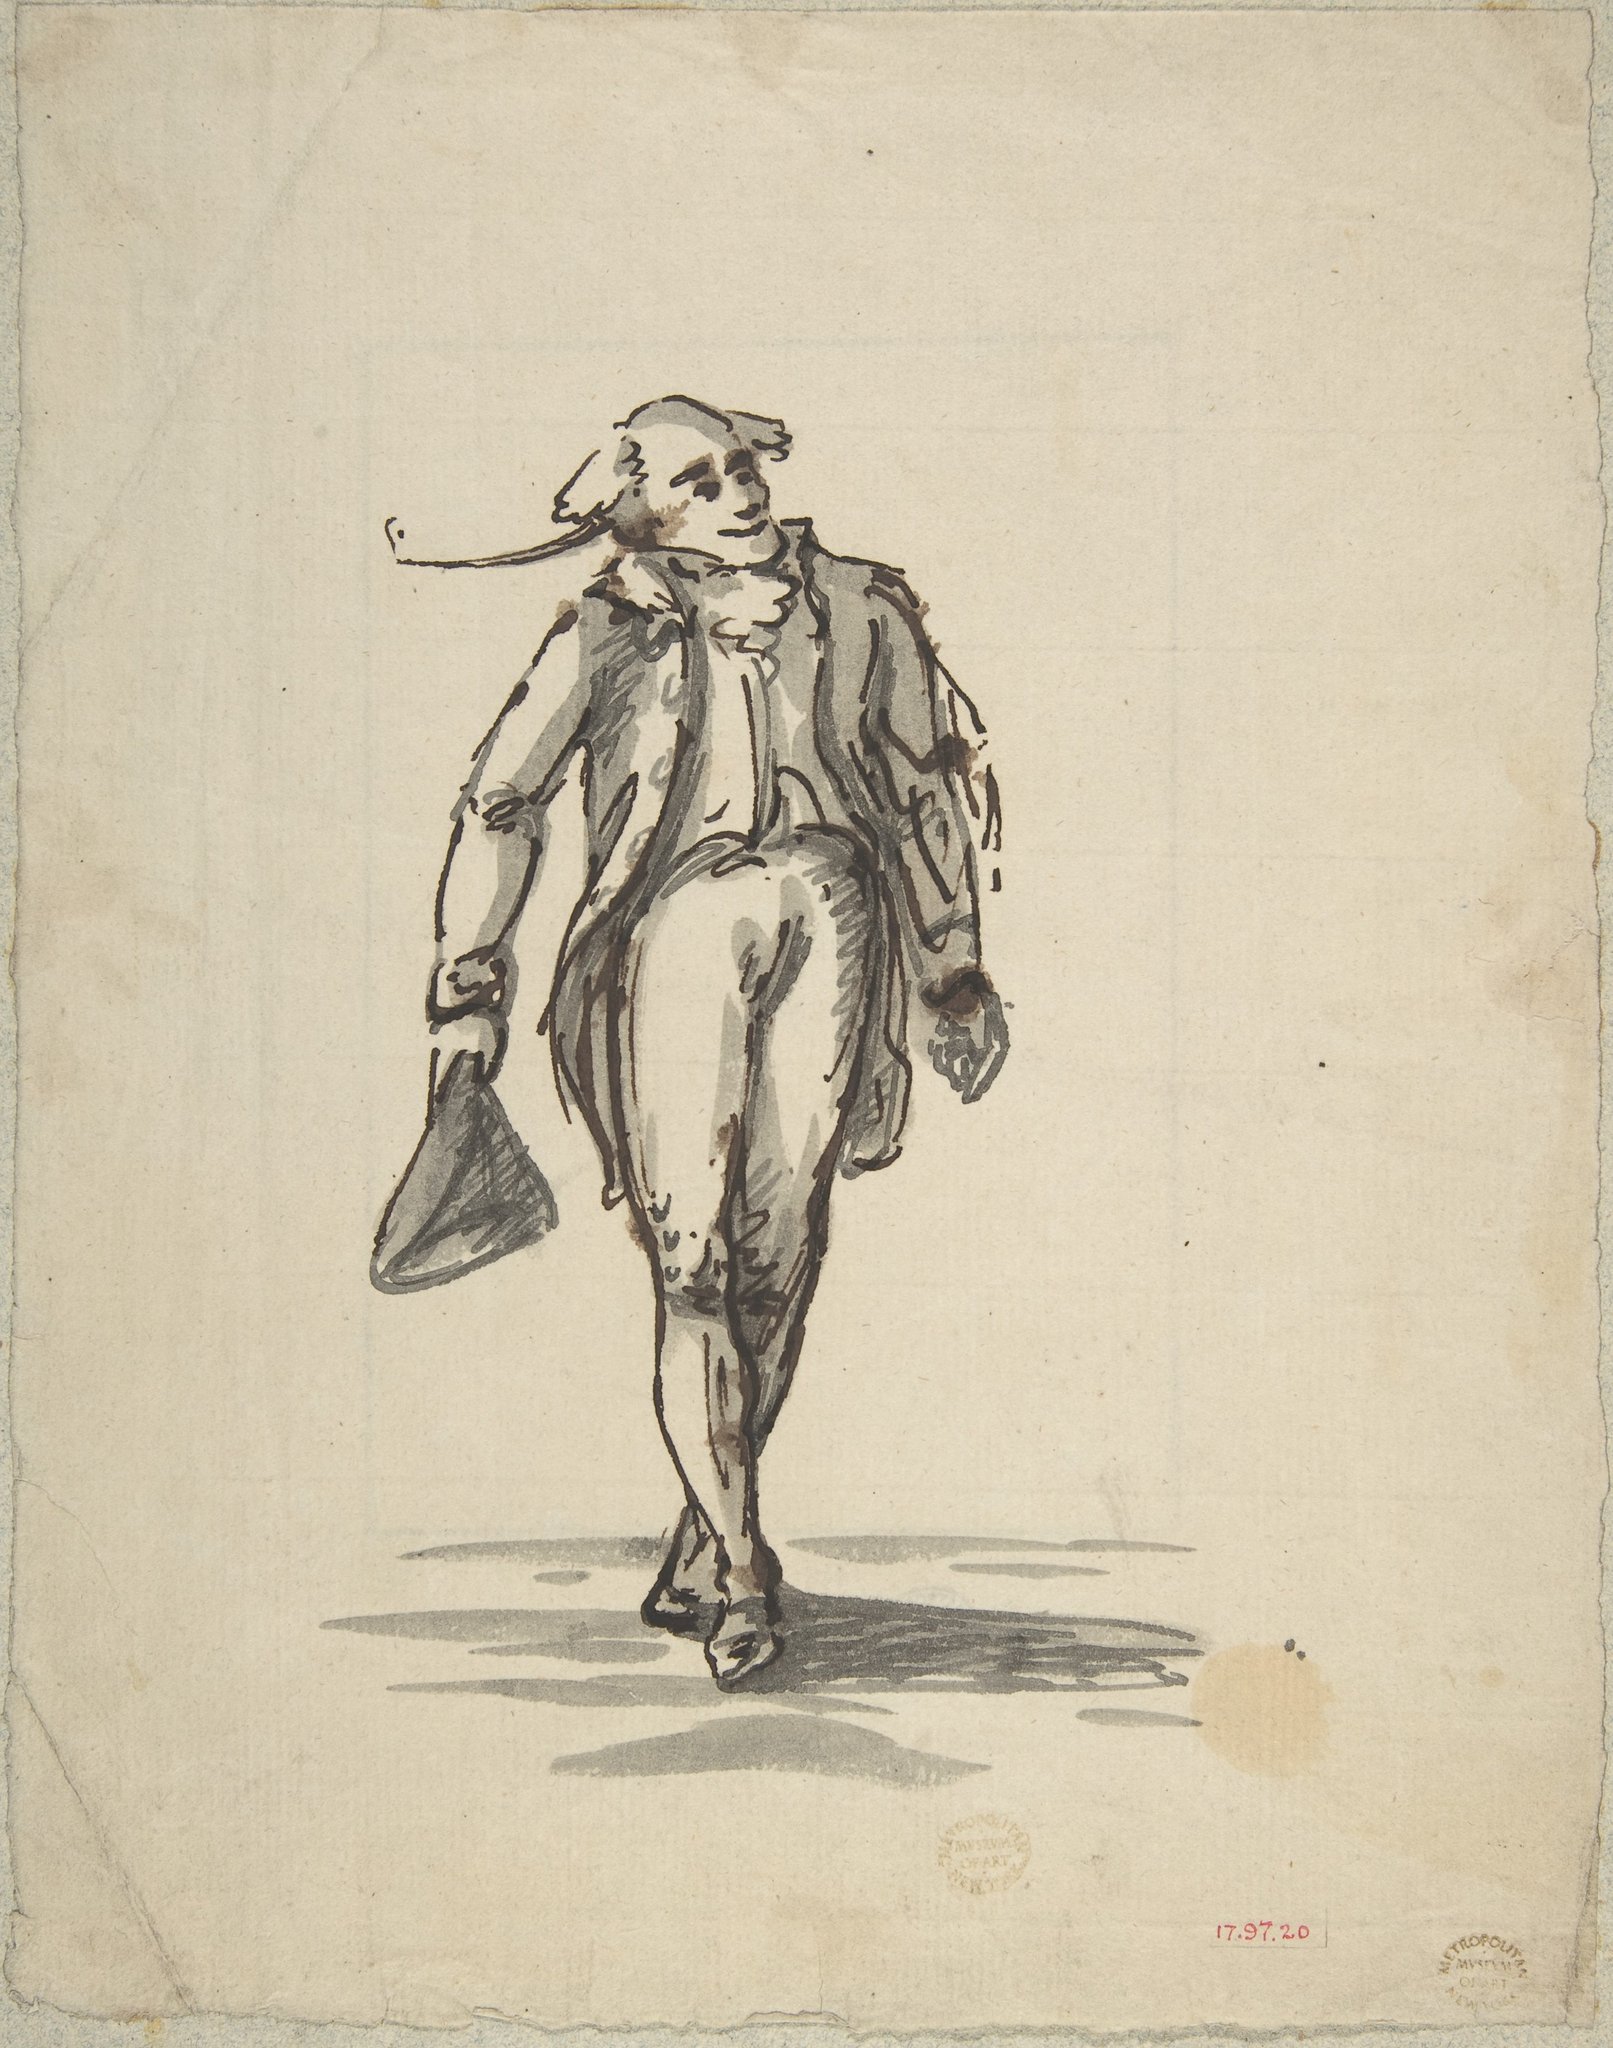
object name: drawing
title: Figure of a Man, the Lawyer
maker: henry william bunbury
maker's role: artist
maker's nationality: british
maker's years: 1750-1811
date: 1790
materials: ink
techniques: brush, pen, wash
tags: men